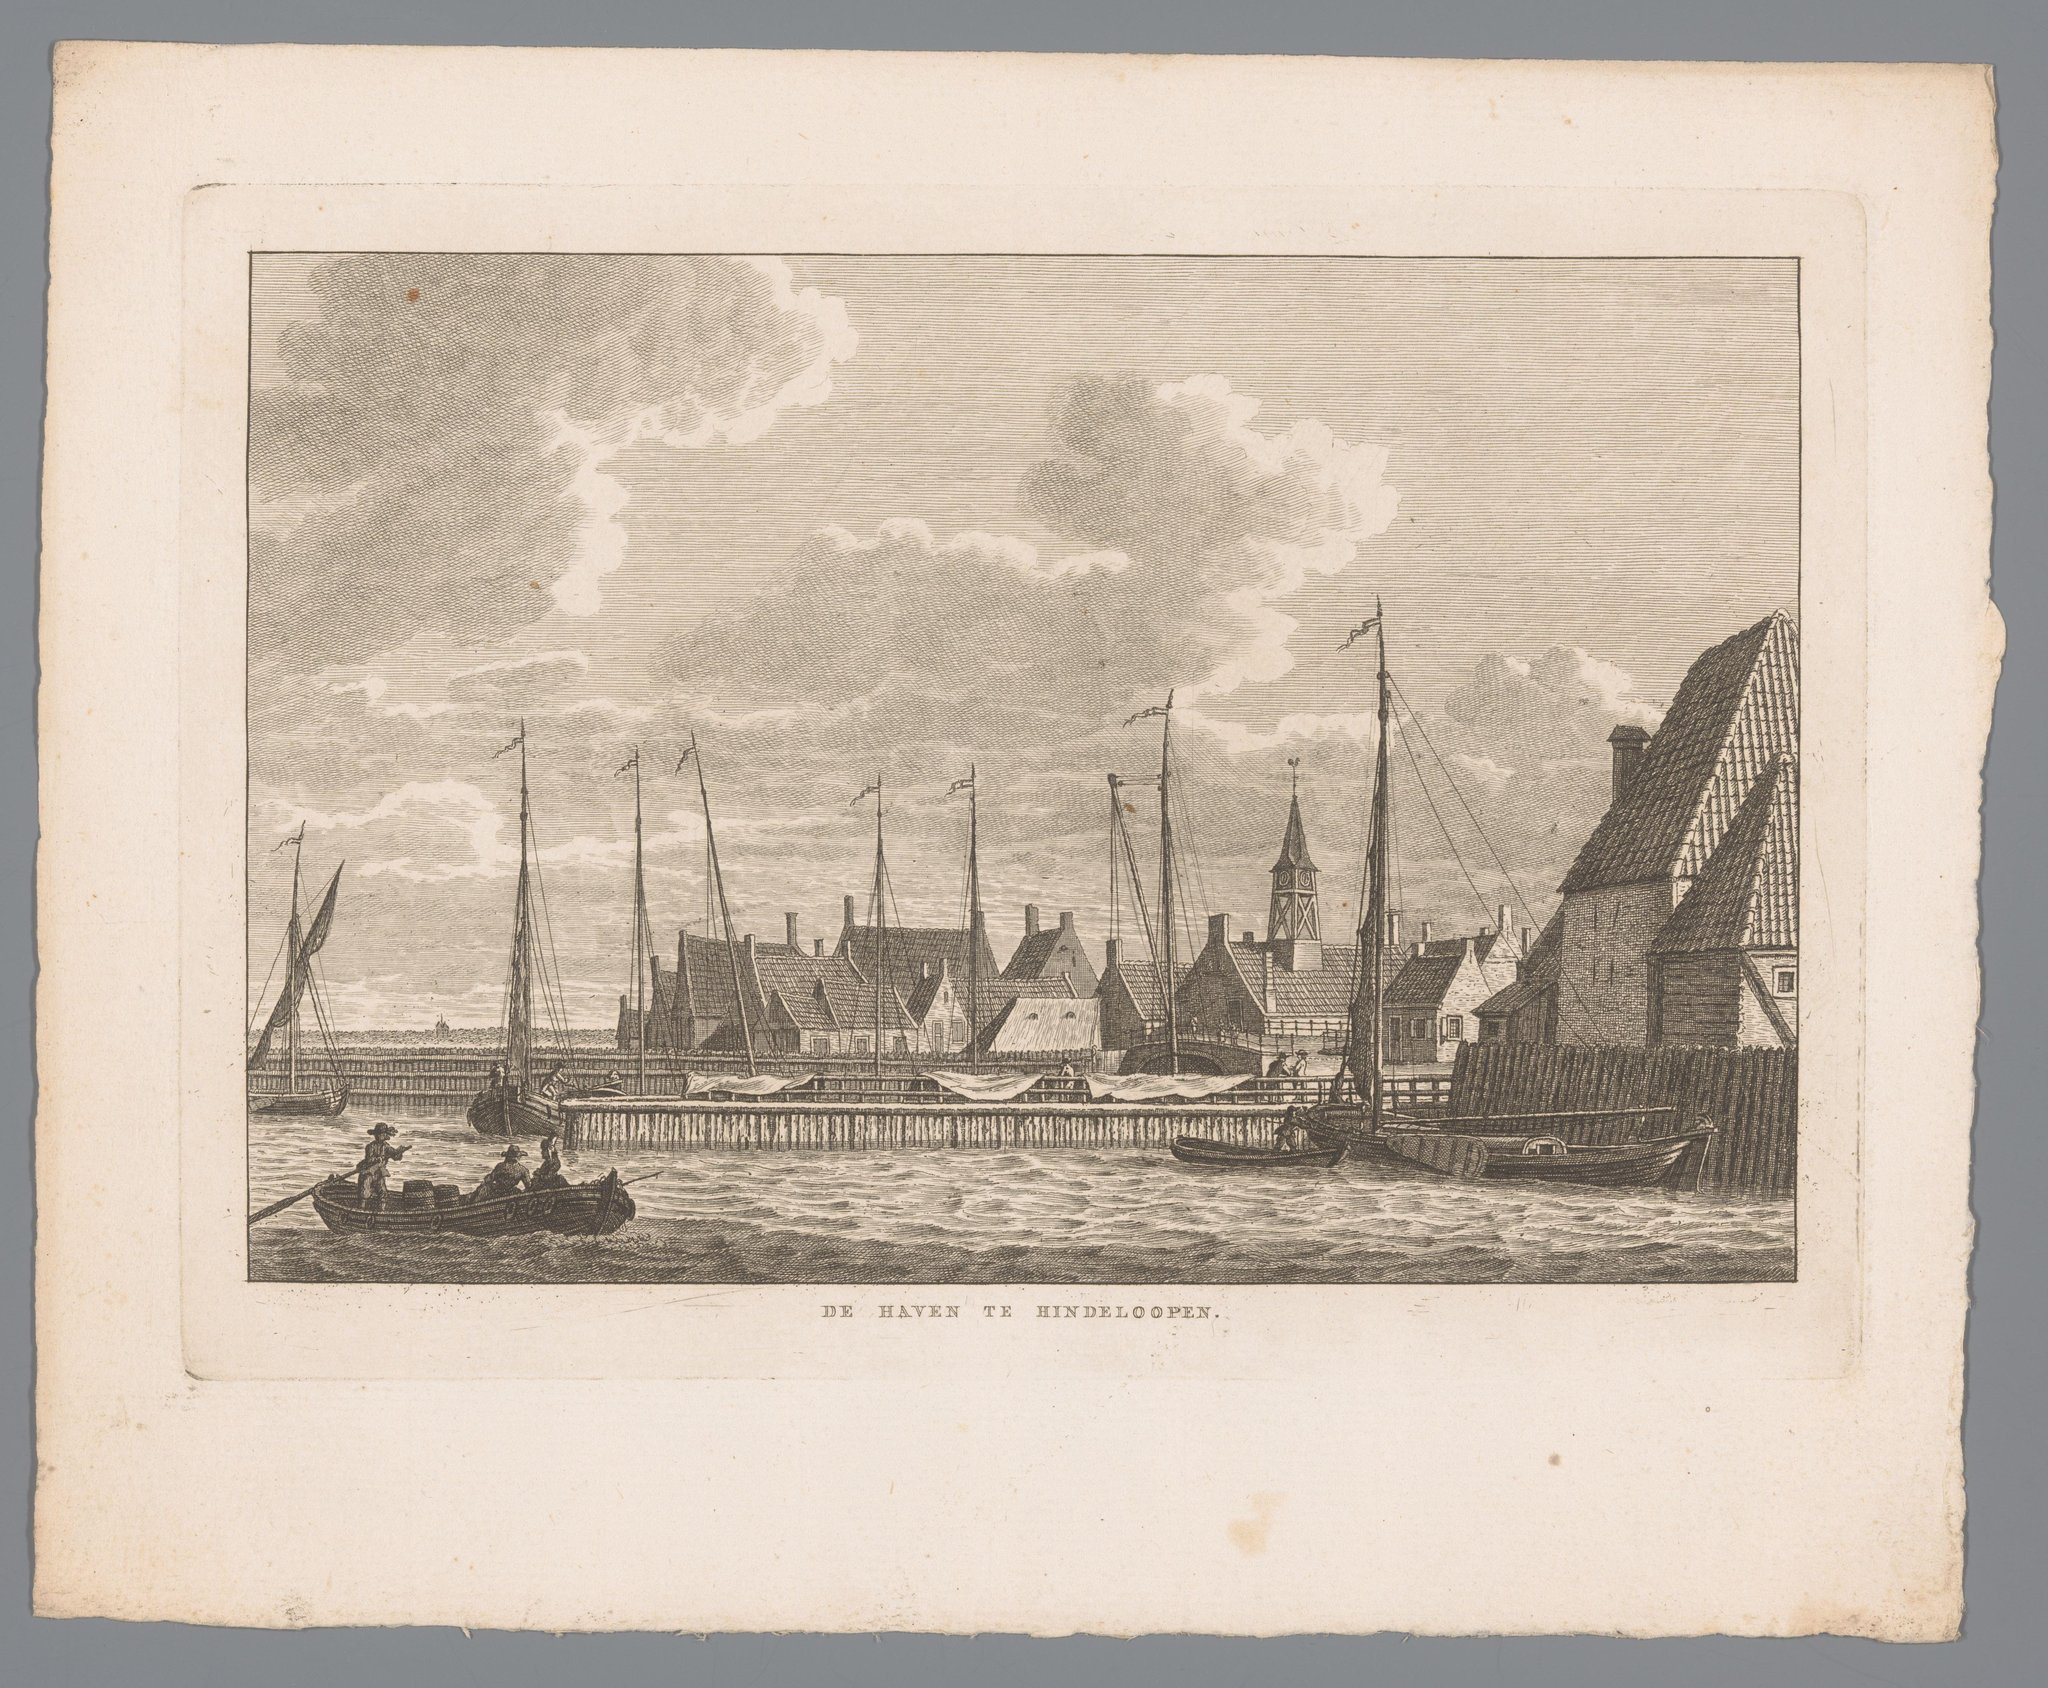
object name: print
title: De haven van Hindeloopen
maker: carel frederik bendorp (i)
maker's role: print maker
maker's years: 1736-1814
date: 1786-1792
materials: paper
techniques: etching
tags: harbour, city-view, and landscape with man-made constructions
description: Prent uit: Vaderlandsche gezichten, of afbeeldingen van den tegenwoordigen staat der Vereenigde Nederlanden (…). Amsterdam: Hendrik Gartman, Willem Vermandel en Jan Willem Smit, 1786-1792. Uitgegeven in afleveringen met ieder een eigen bifolium en inhoudsopgave. Alle prenten in deze publicatie zijn gegraveerd door Carel Frederik Bendorp (I) en, in de meeste gevallen, gebaseerd op tekeningen van Jan Bulthuis.